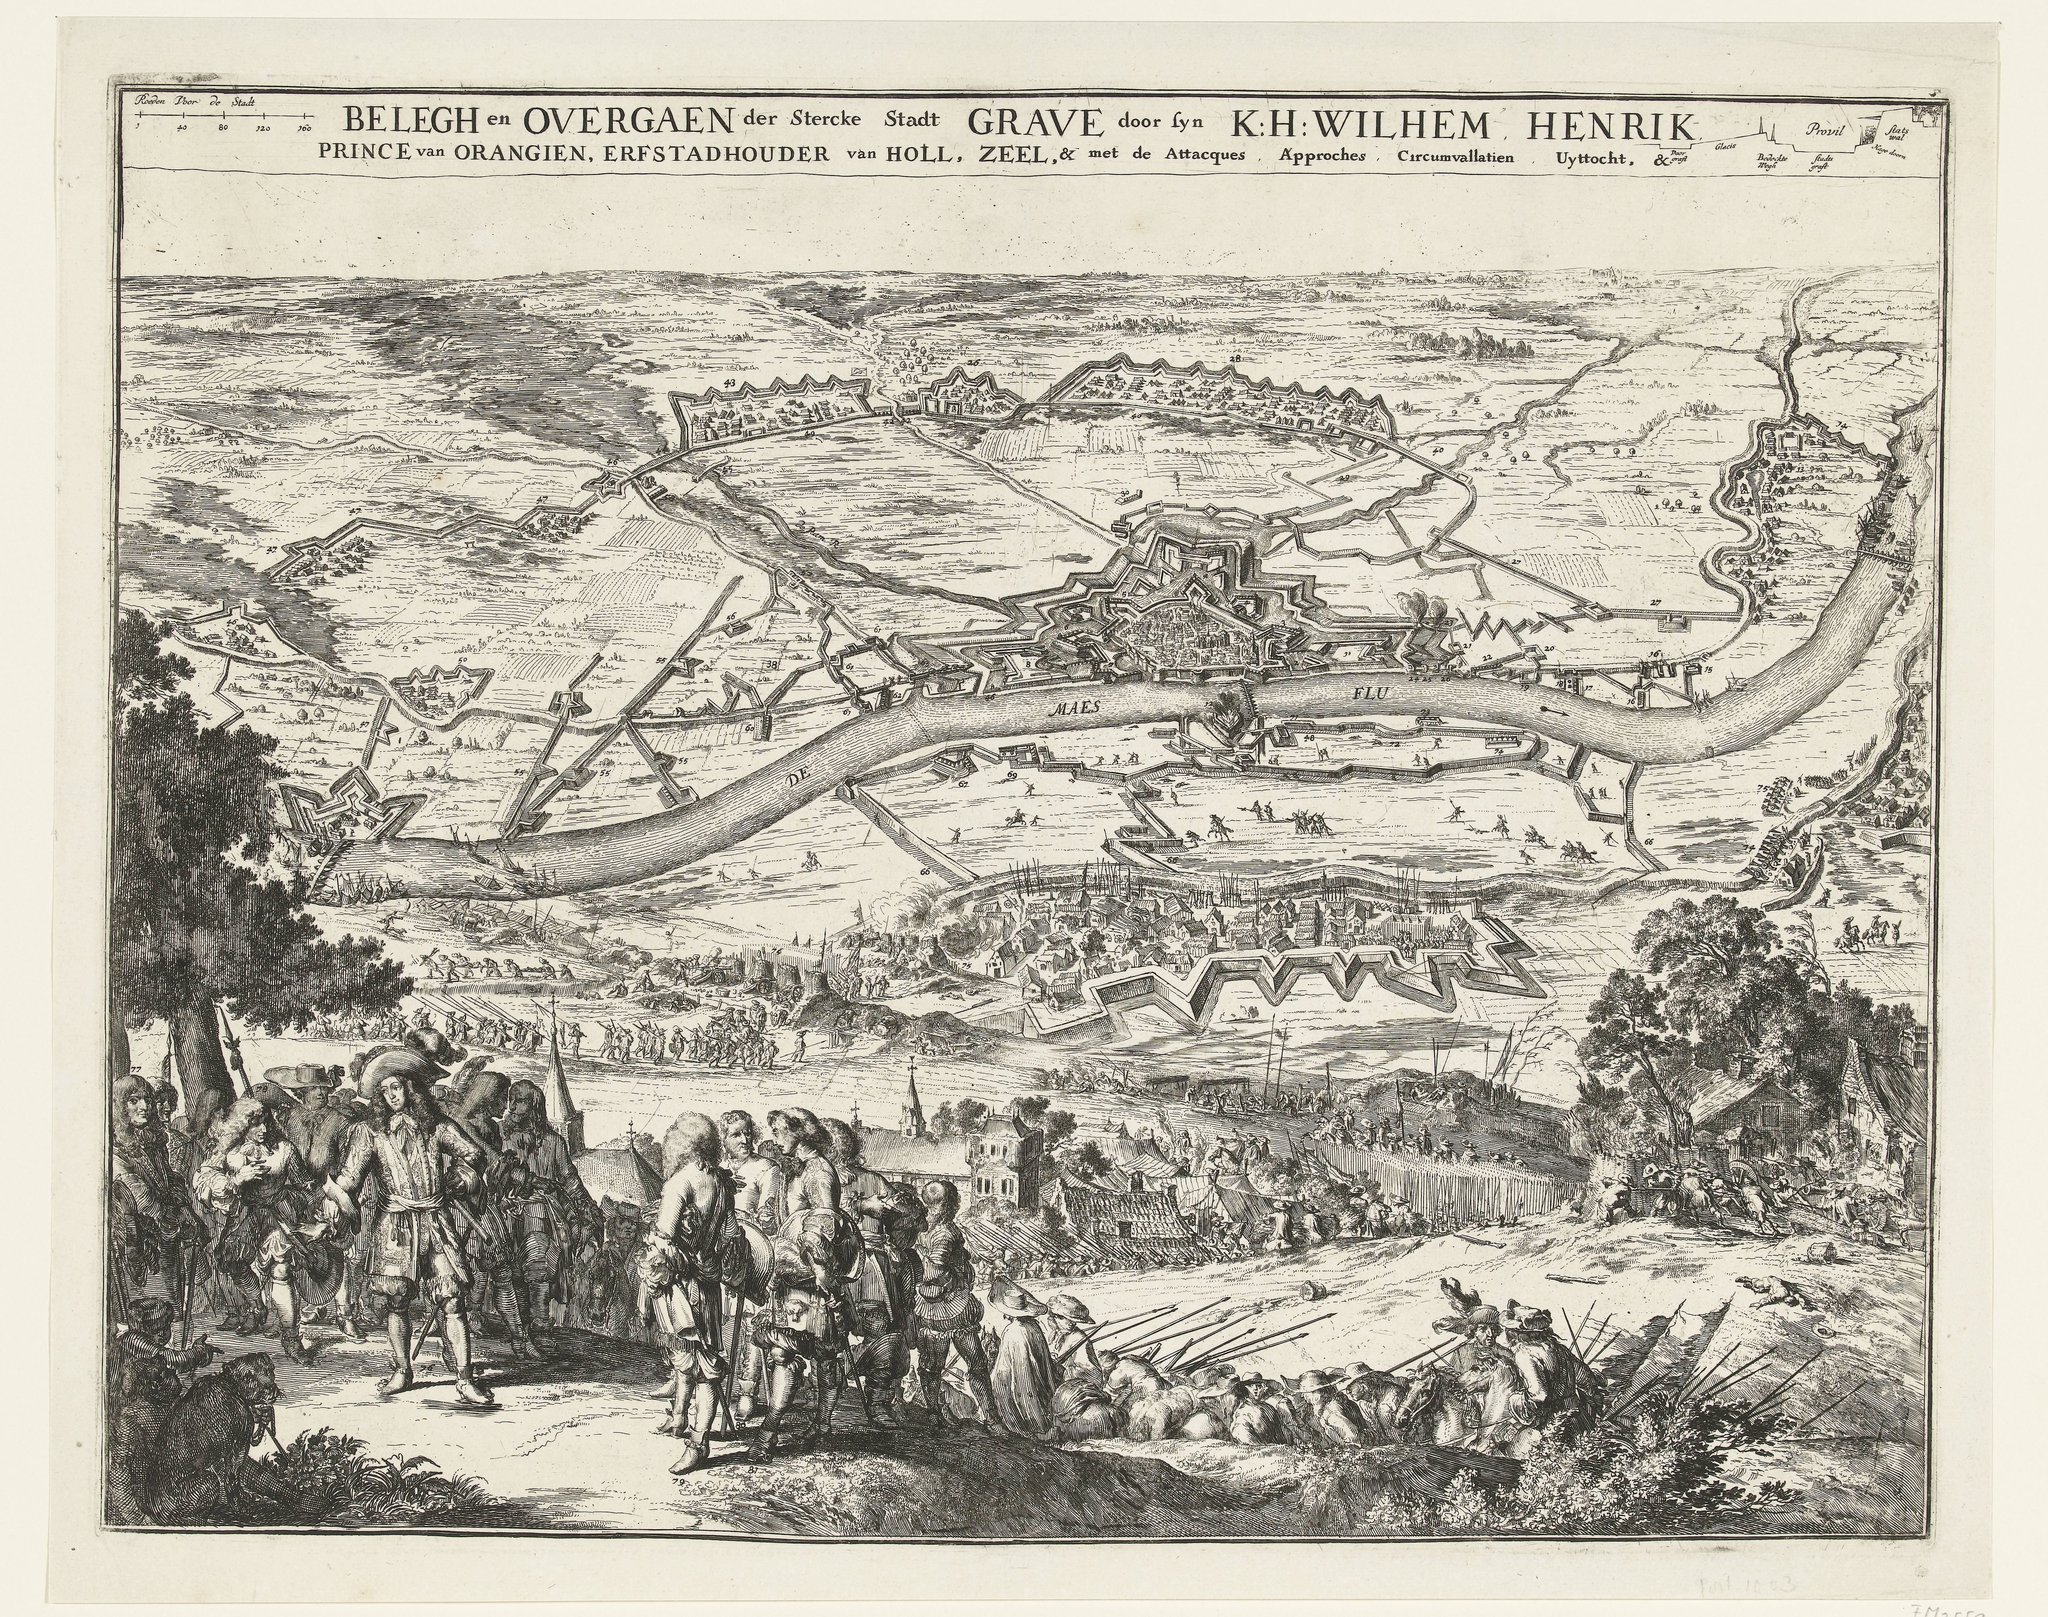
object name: print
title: Beleg en verovering van Grave door Willem III, 1674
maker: romeyn de hooghe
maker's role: draughtsman, goldsmith, painter, print maker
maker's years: 1645-1708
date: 1674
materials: paper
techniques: etching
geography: netherlands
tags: the hague, william iii (prince of orange and king of england, scotland, and ireland), siege, position war, grave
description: Beleg en verovering van Grave door Willem III, 25 juli tot 29 oktober 1674. Hoofdvoorstelling met een gezicht op de belegerde stad Grave aan de rivier de Maas en de posities van de belegerende troepen. Op de voorgrond Willem III met zijn staf.